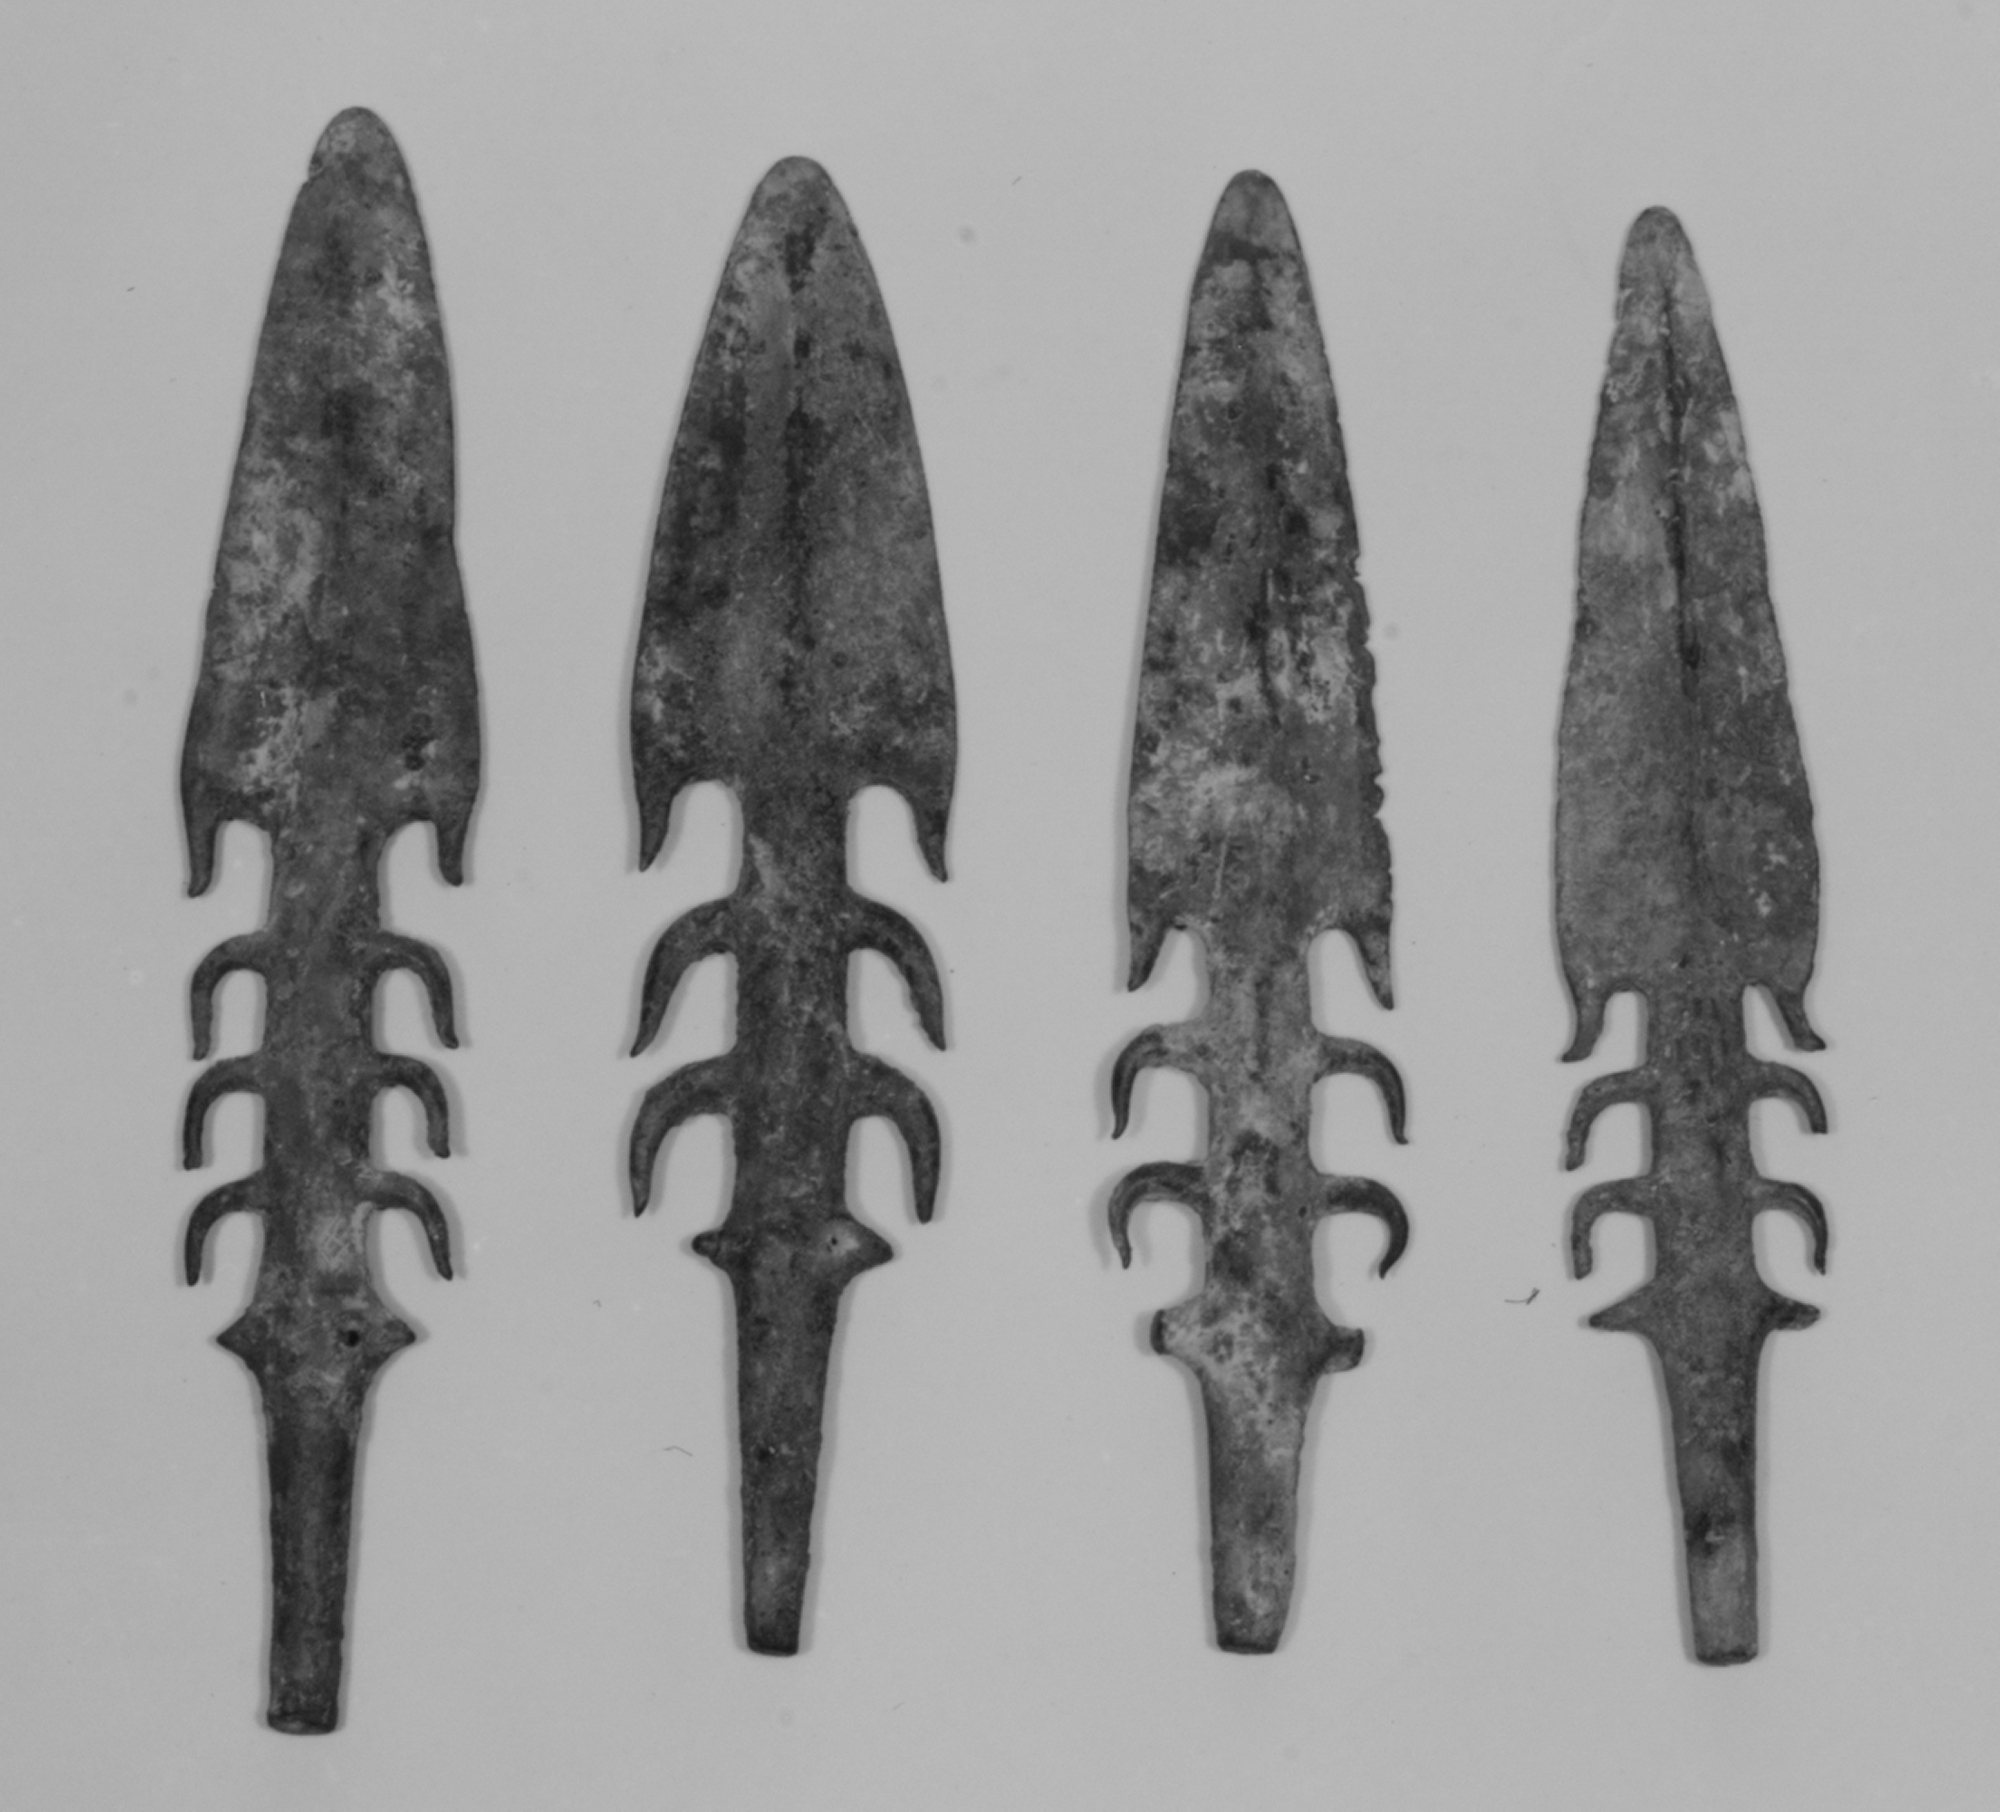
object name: harpoon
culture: indian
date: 1500-500 BCE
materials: copper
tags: gandhara